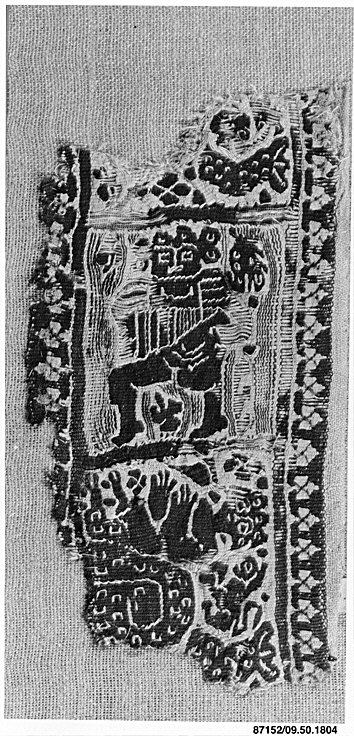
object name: band fragment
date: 301-500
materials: linen, wool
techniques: weave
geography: egypt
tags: human figures